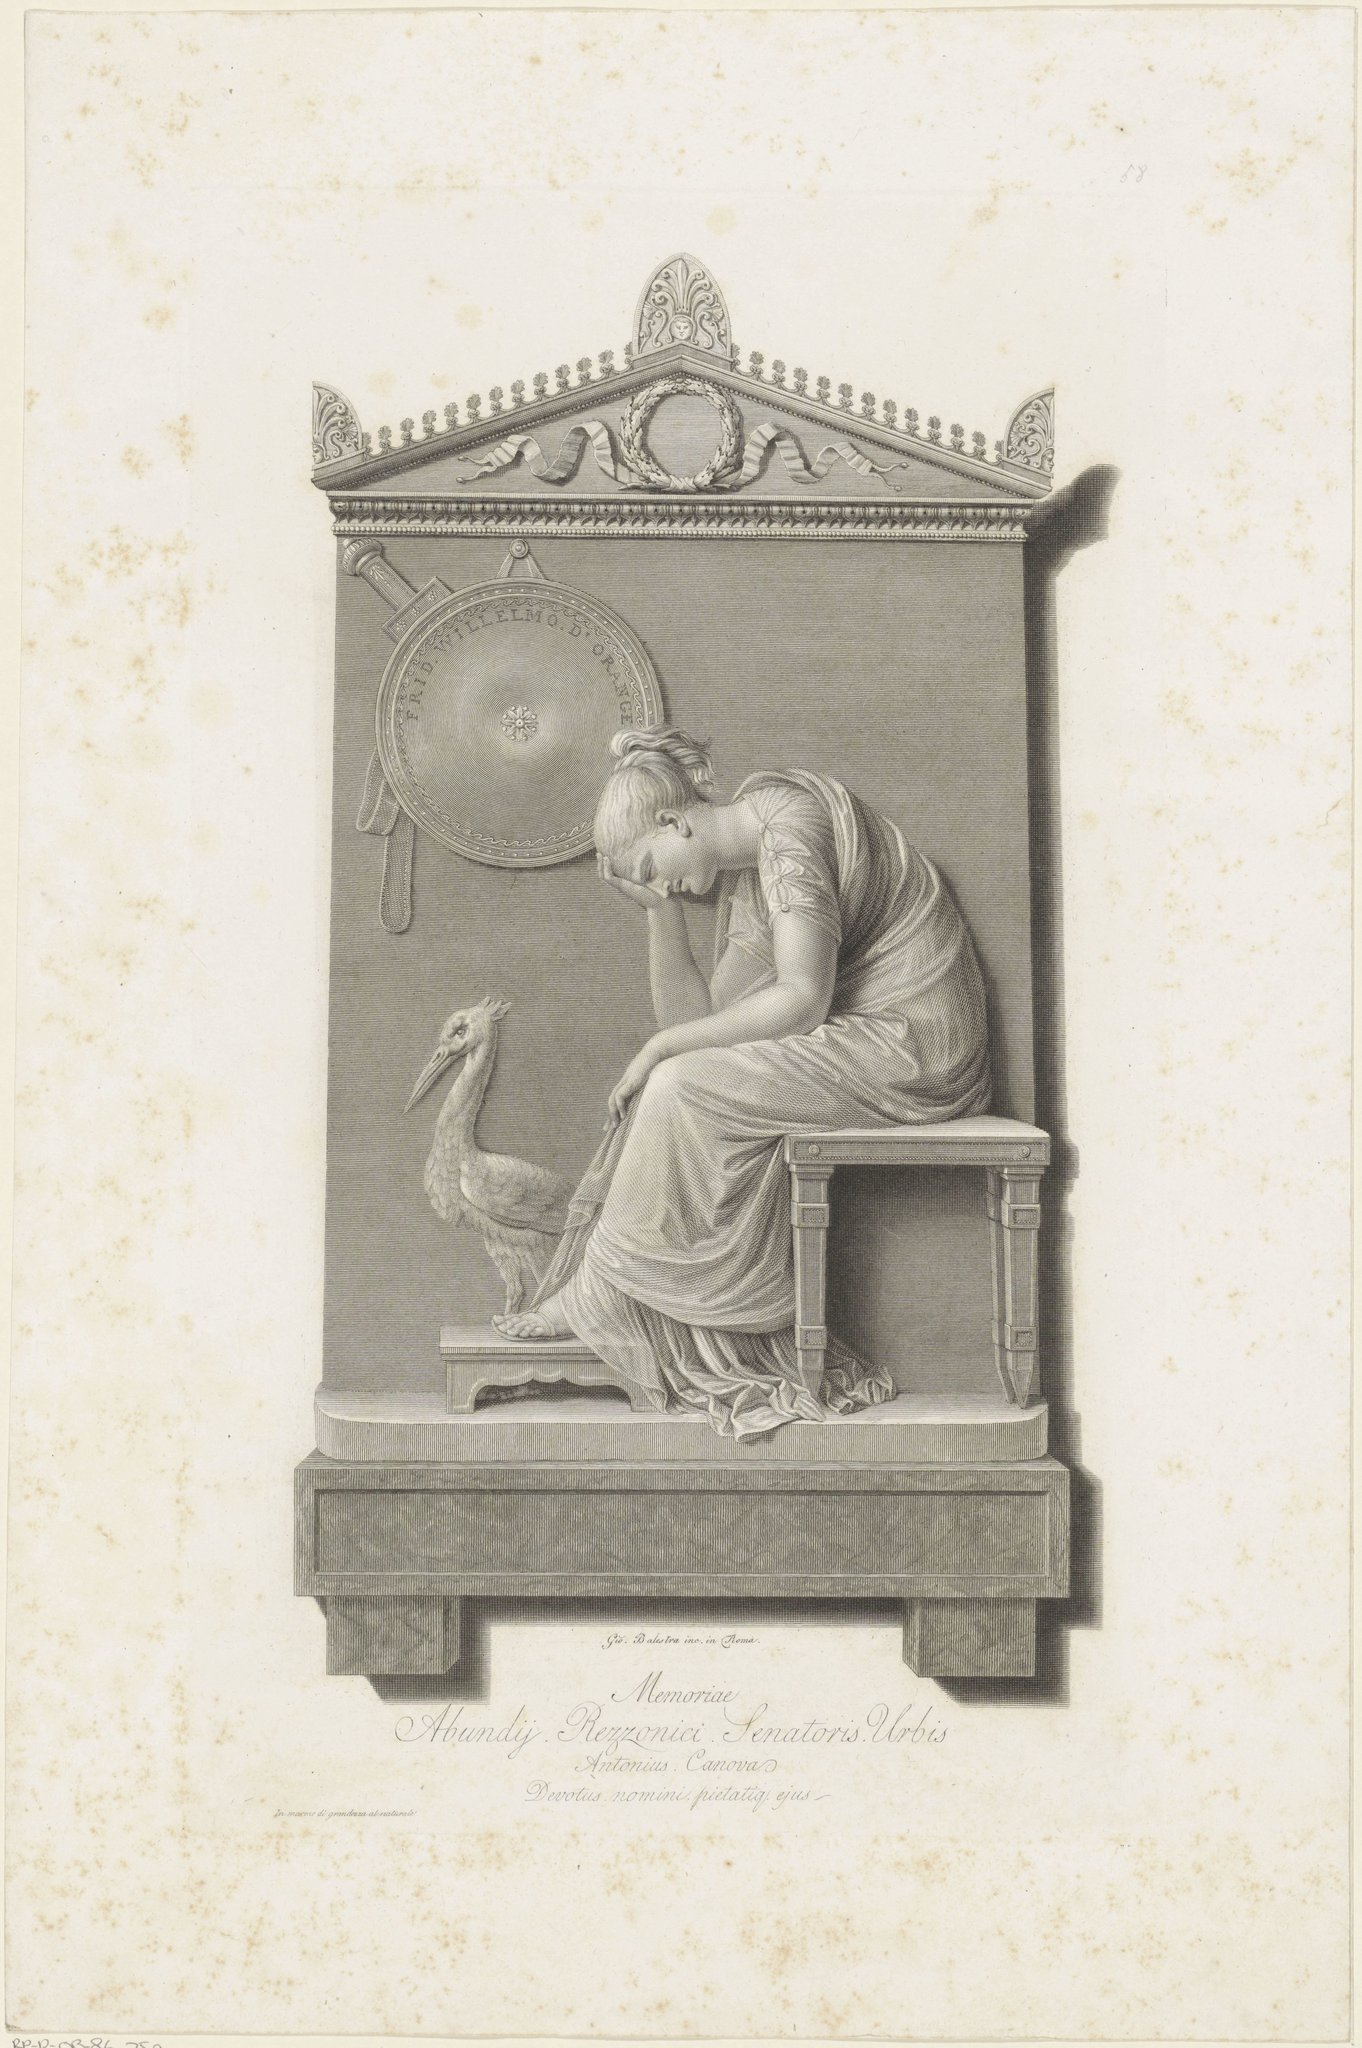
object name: print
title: Memoriae Abundij Rezzonici Senatoris Urbis (...)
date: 1807-1842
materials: paper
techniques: engraving, etching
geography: rome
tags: the hague, willem george frederik (prins van oranje-nassau), shore-birds and wading-birds: stork, grave-building, monumental tomb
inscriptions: collector's mark: Lugt 12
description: Grafmonument voor Frederik door Antonio Canova in de kruisgang van het Heremietenklooster te Padua, overleden op 6 januari 1799. Een treurende vrouw zit naast een ooievaar. Aan de muur een zwaard en een schild met randschrift. In de ondermarge vier regels Latijnse tekst.